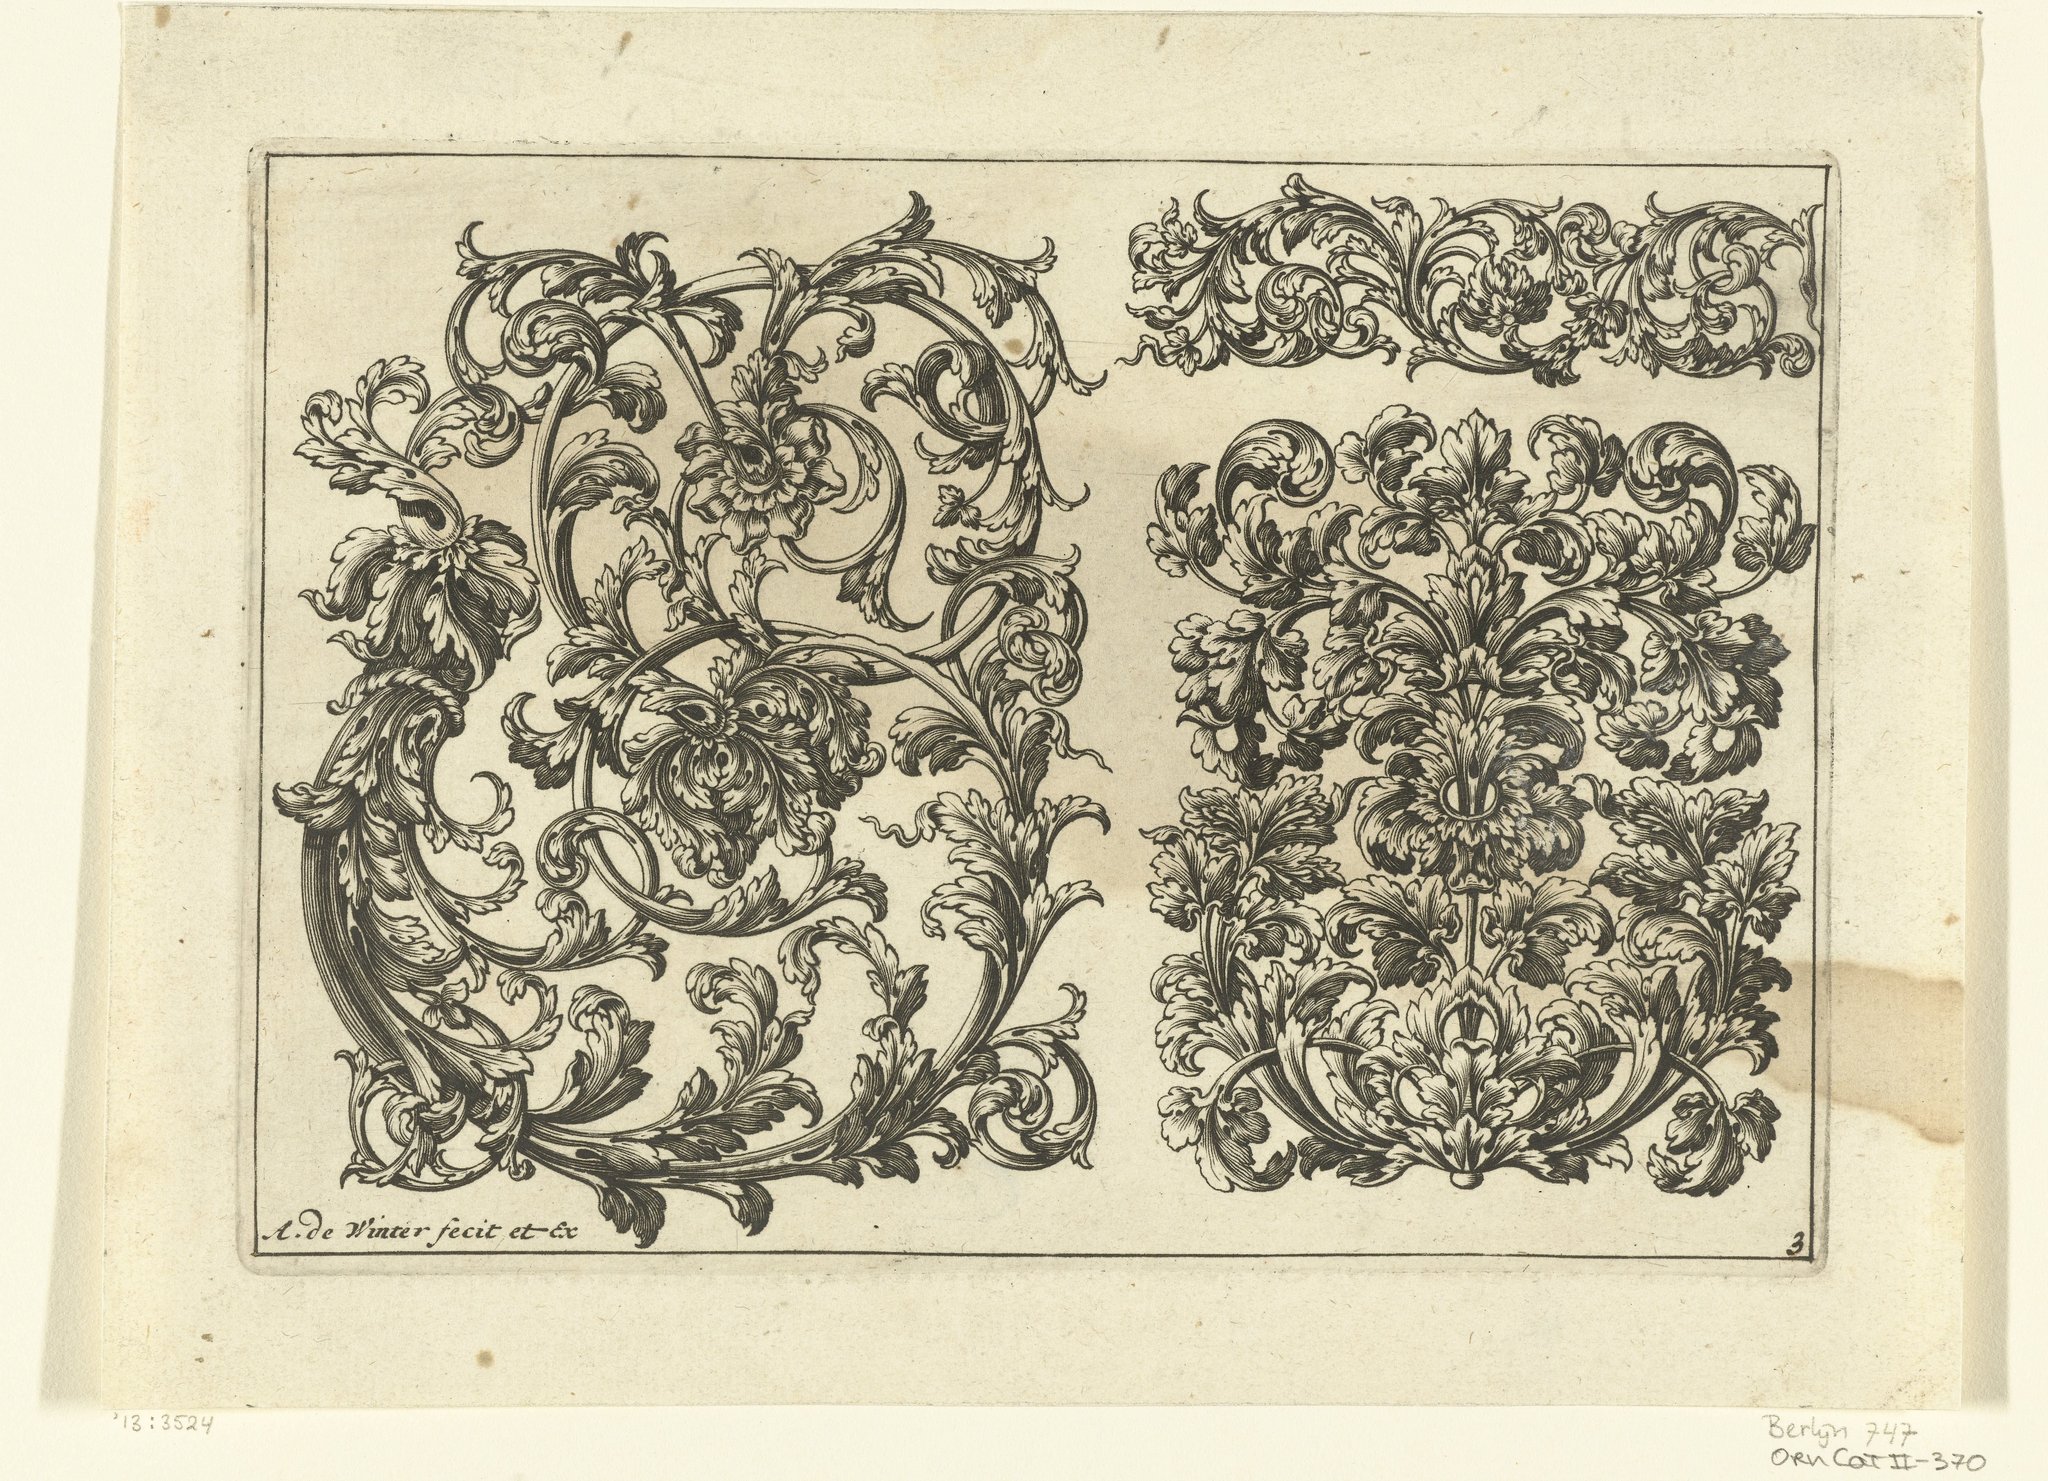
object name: print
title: Twee verticale motieven en een smal fries van bladranken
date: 1690-1700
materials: paper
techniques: engraving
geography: amsterdam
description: Blad uit serie met kopieën naar Stefano della Bella, Gilles Légaré, Thomas Lejuge en anderen.